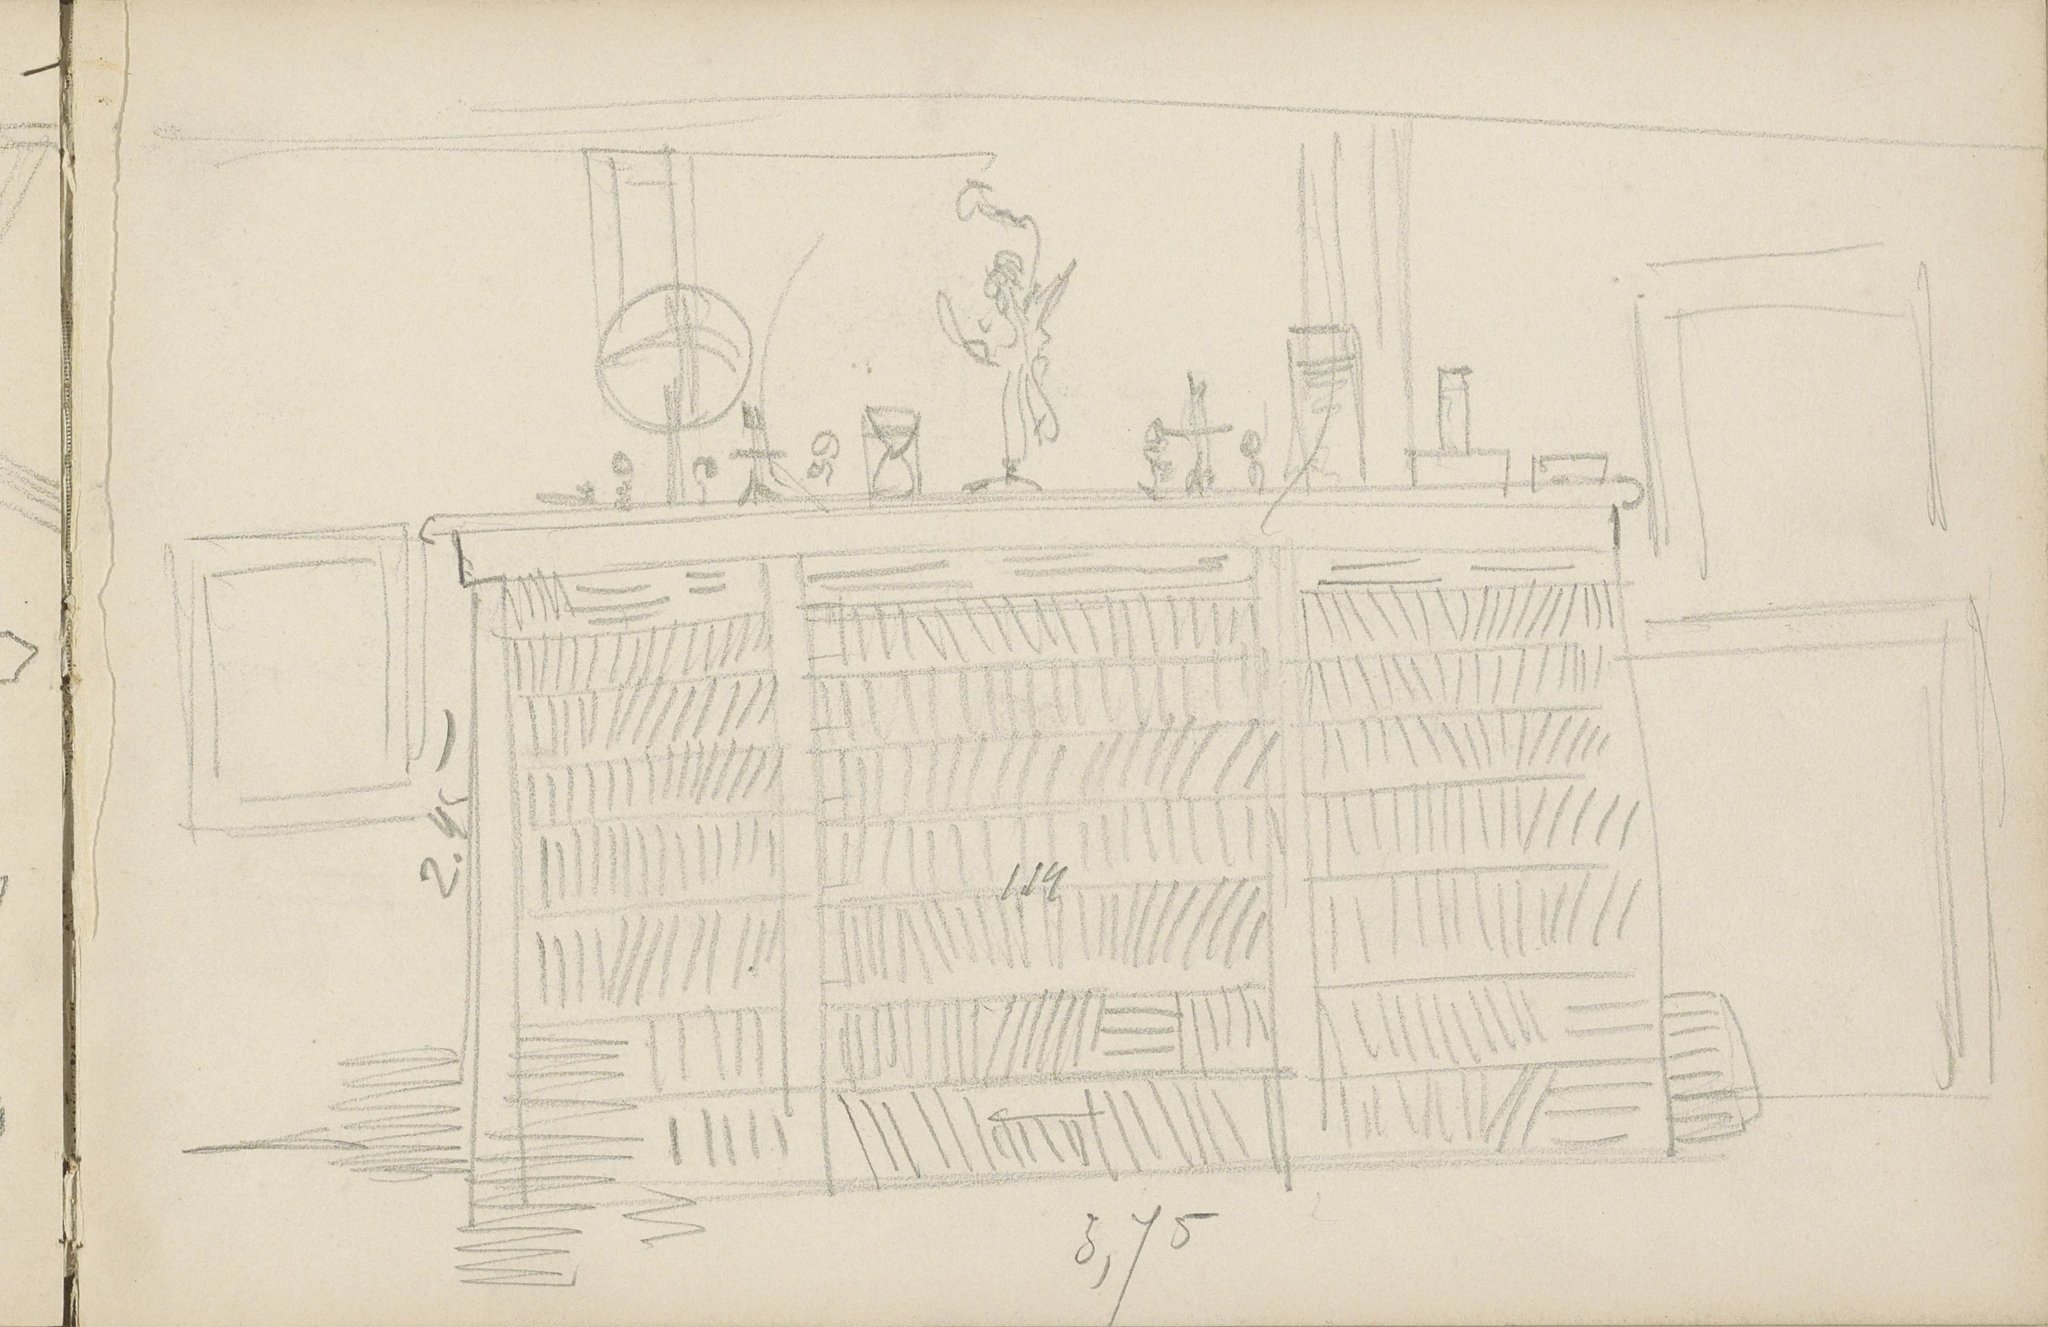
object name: sketchbook leaf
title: Objecten op een schoorsteenmantel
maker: carel adolph lion cachet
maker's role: draughtsman, print maker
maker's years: 1864-1945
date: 1908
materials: paper, pencil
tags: chimney-piece, mantelpiece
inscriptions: annotation: ‘[...]’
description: Blad 3 recto uit een schetsboek met 25 bladen.